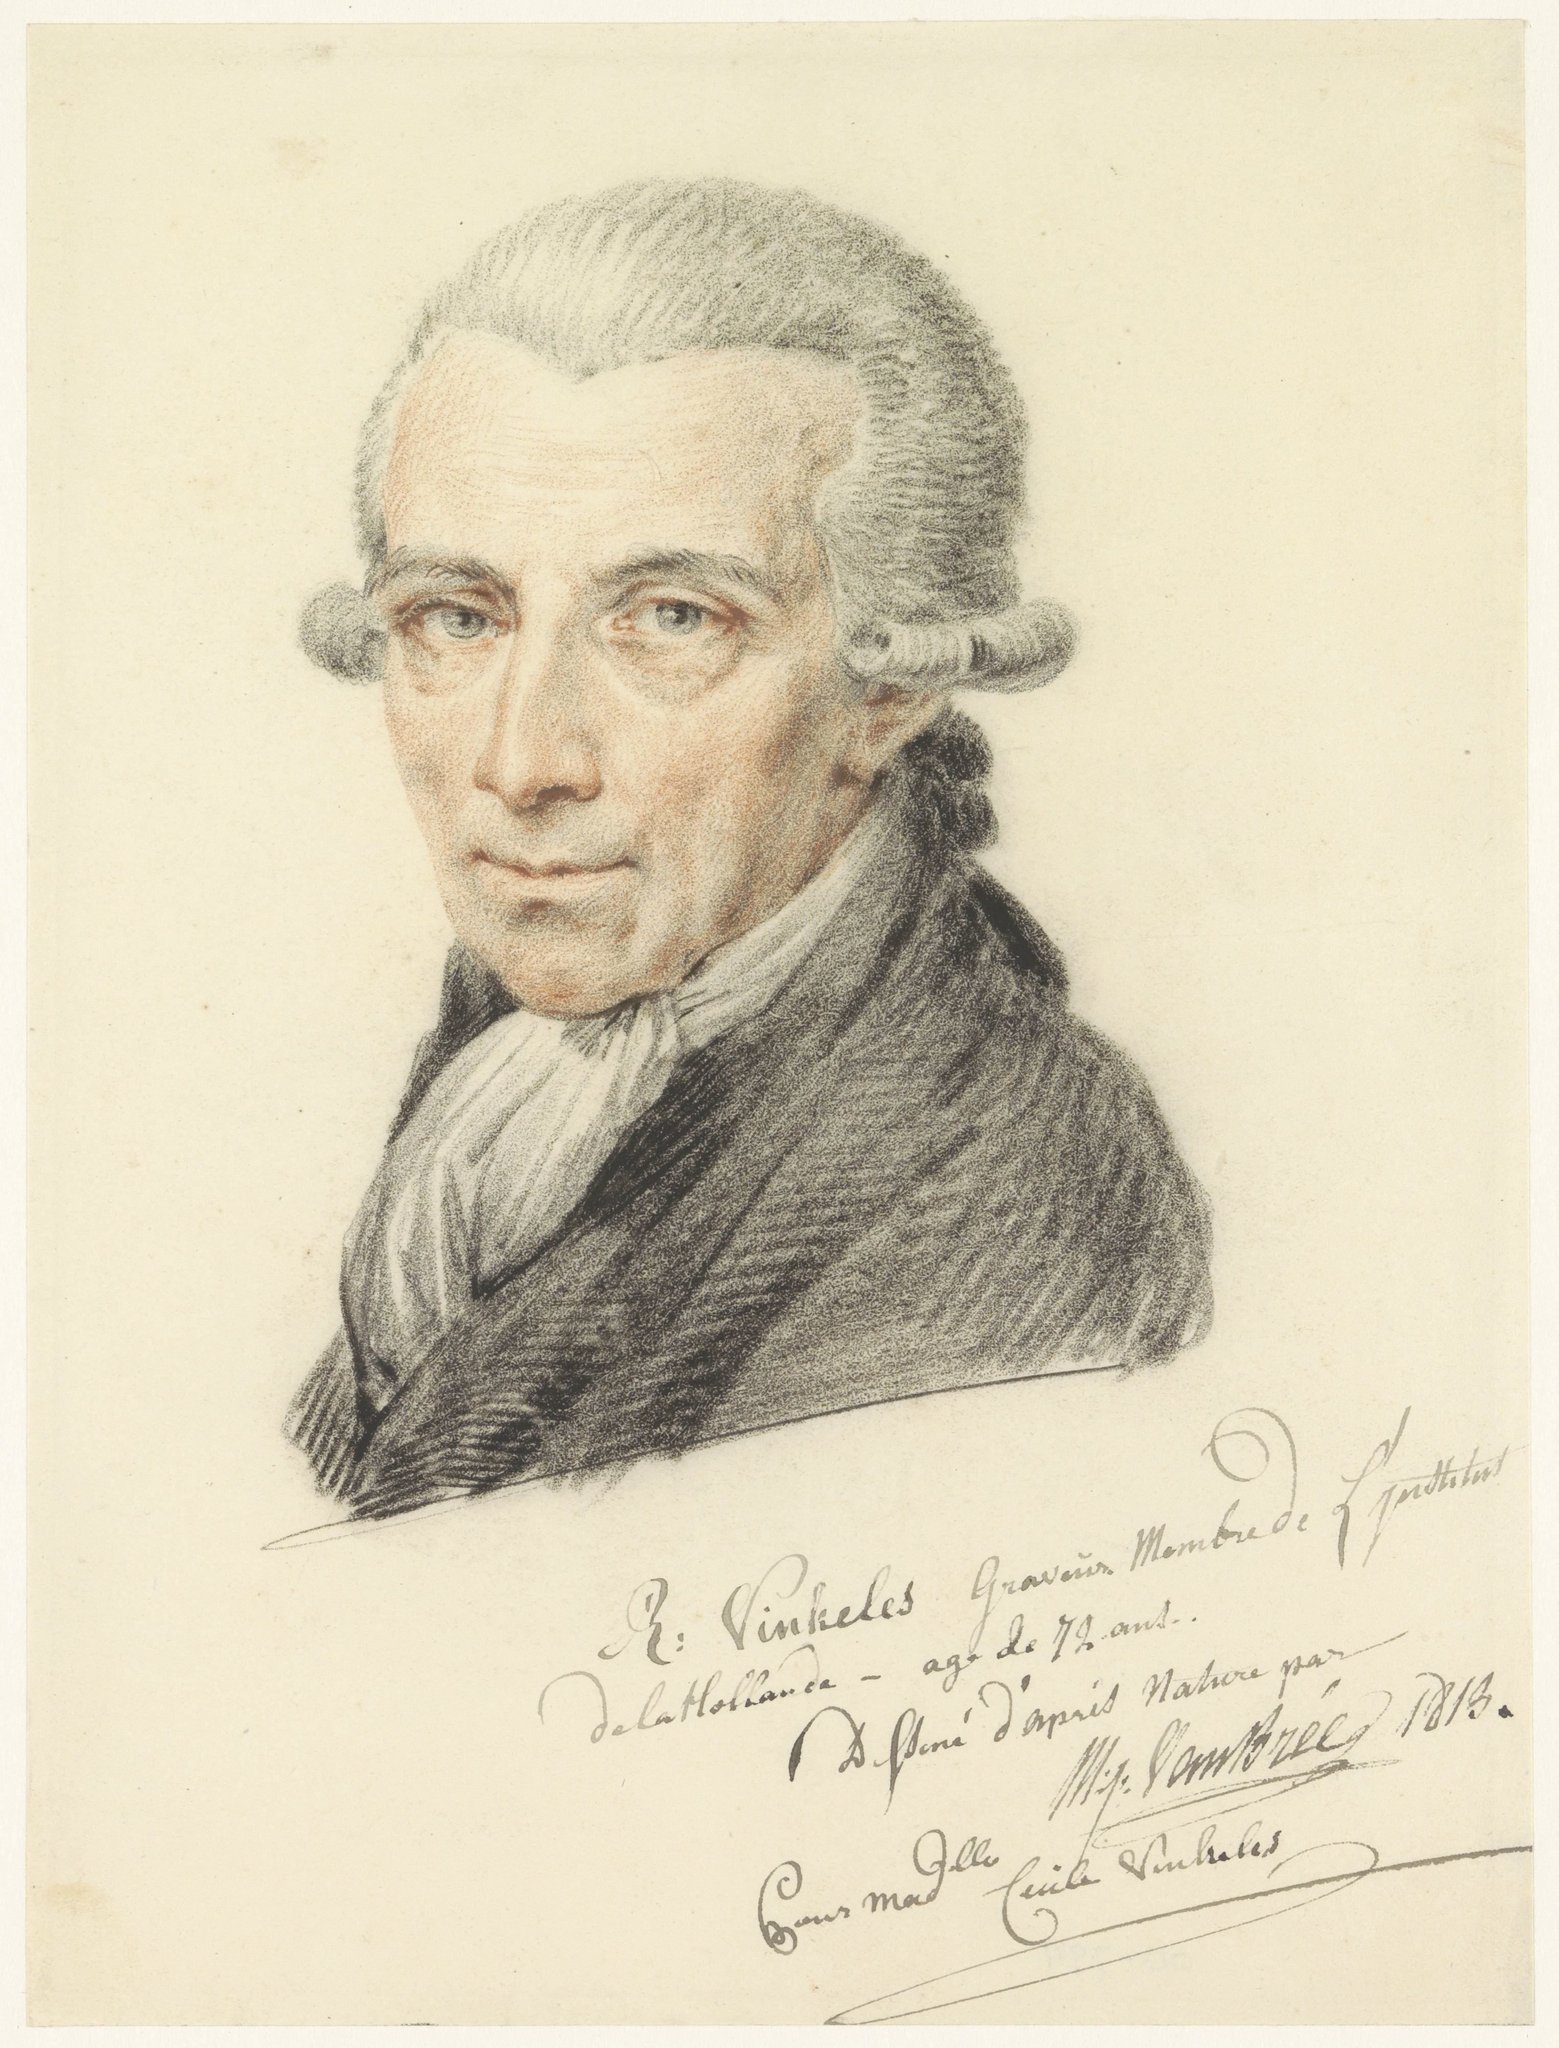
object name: drawing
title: Portret van Reinier Vinkeles I op 72-jarige leeftijd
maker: mattheus ignatius van bree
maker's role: draughtsman, print maker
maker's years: 1773-1839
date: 1813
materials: chalk, paper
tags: amsterdam, reinier vinkeles (i), historical persons, portrait, self-portrait of artist, portrait, self-portrait of graphic artist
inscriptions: date: ‘1813’